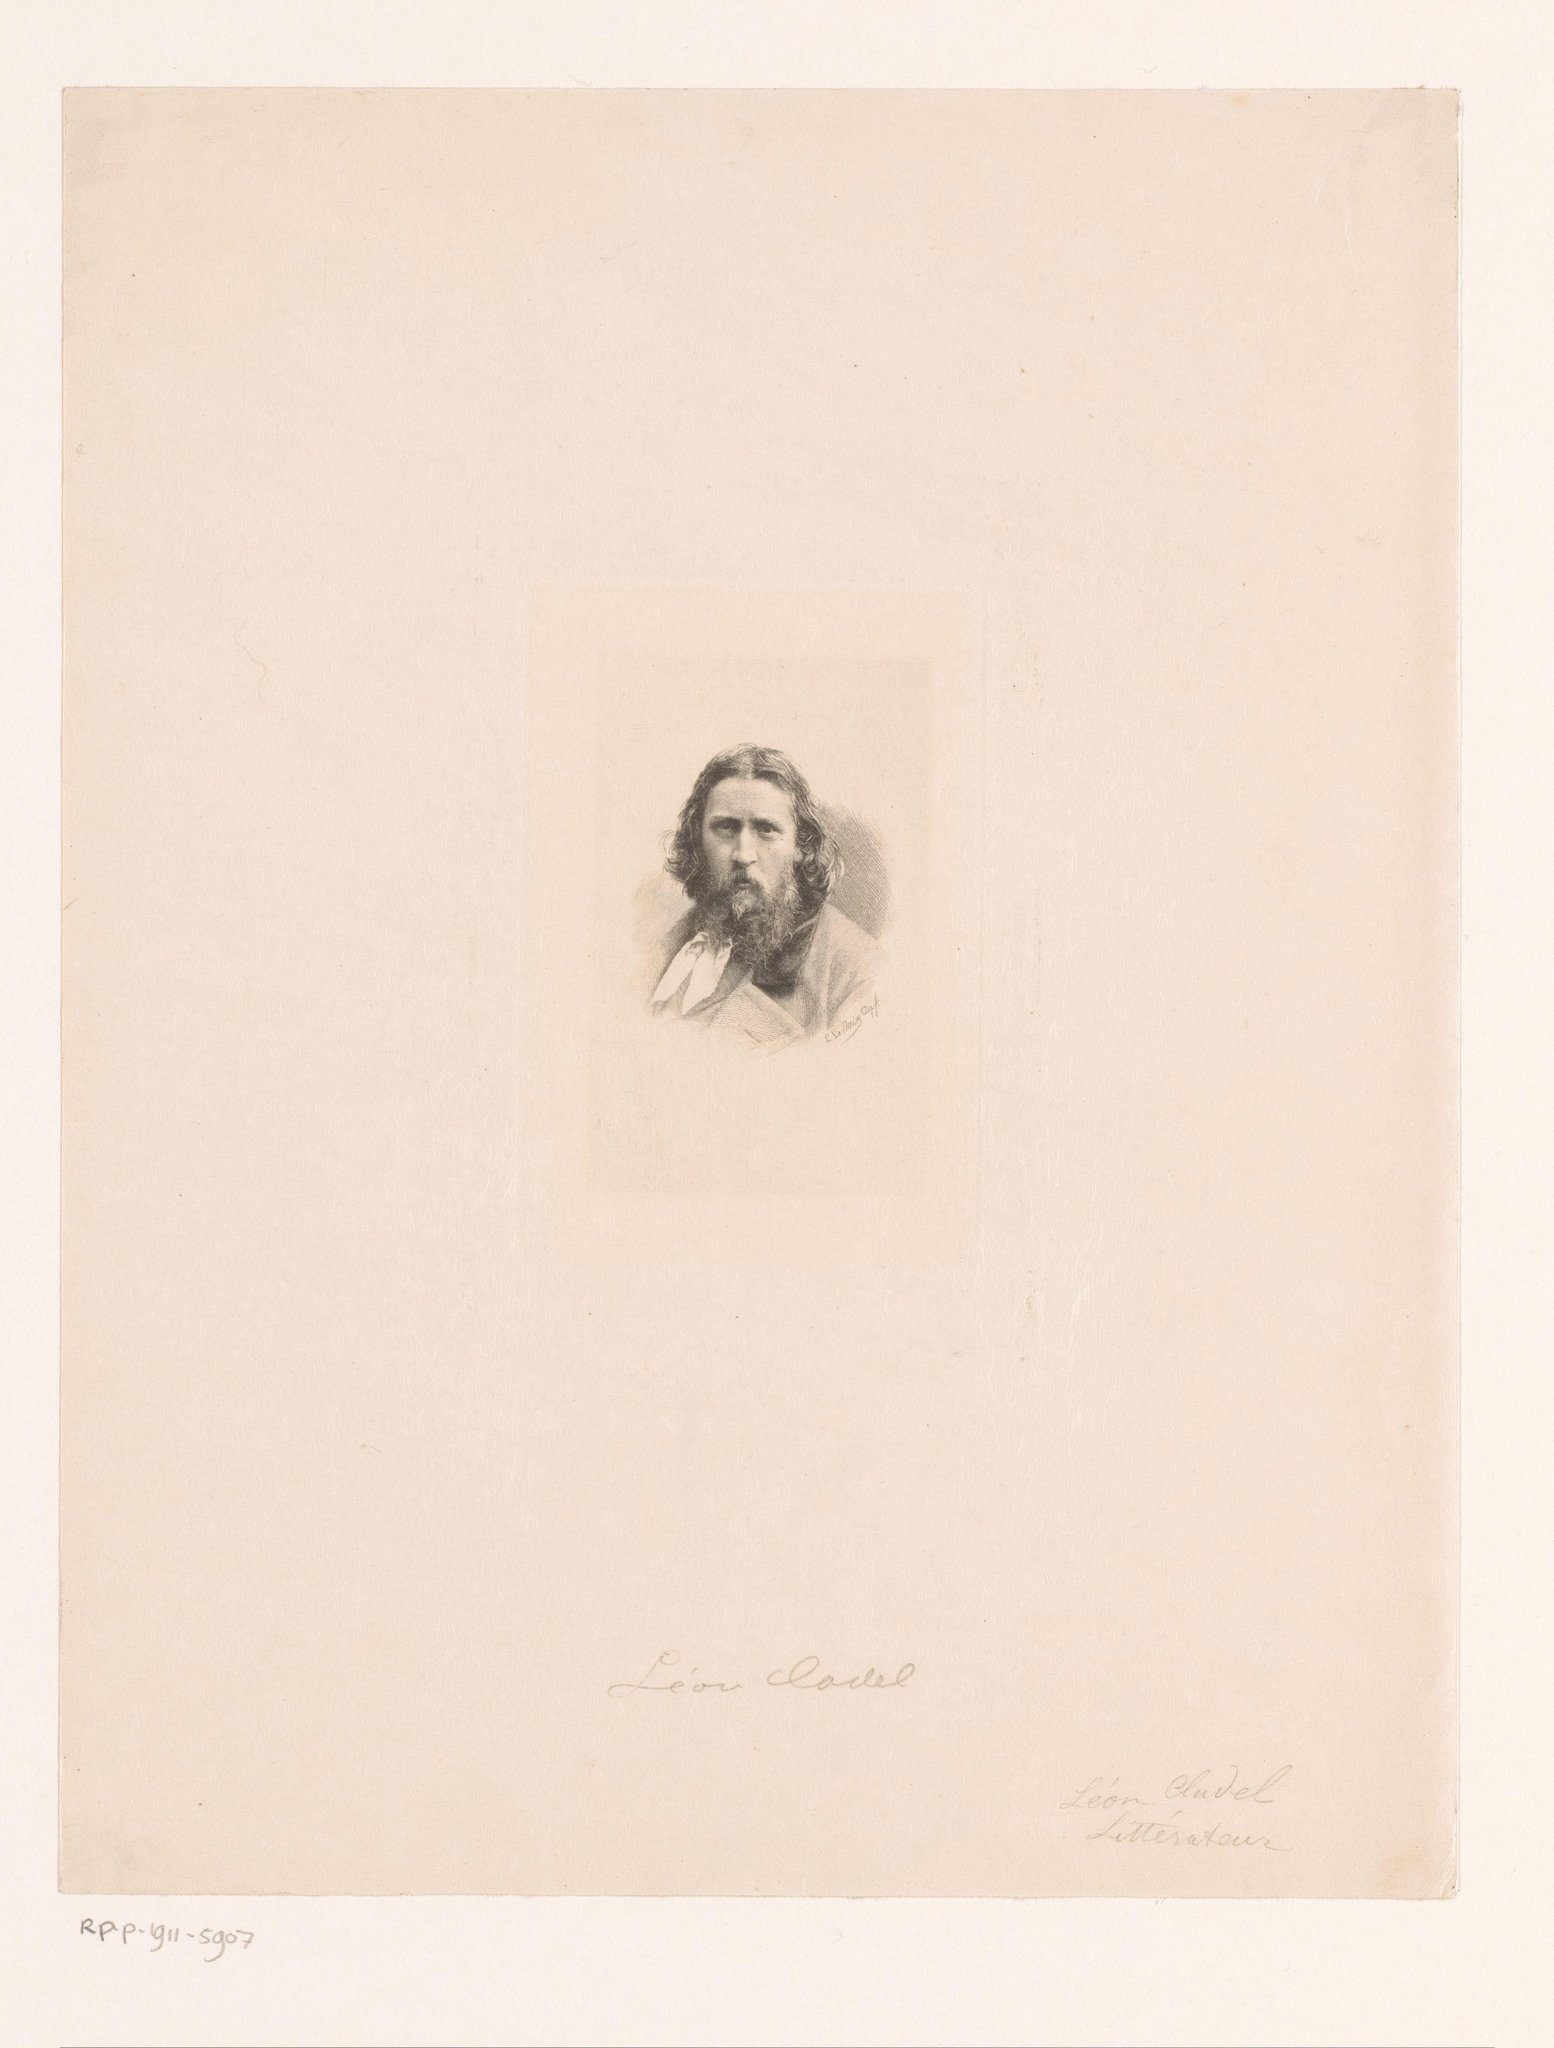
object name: print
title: Portret van Léon Cladel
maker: louis le nain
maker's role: print maker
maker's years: 1851-1939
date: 1861-1911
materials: paper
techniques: etching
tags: léon cladel, adult man, historical persons, beard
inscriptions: collector's mark: Lugt 2228